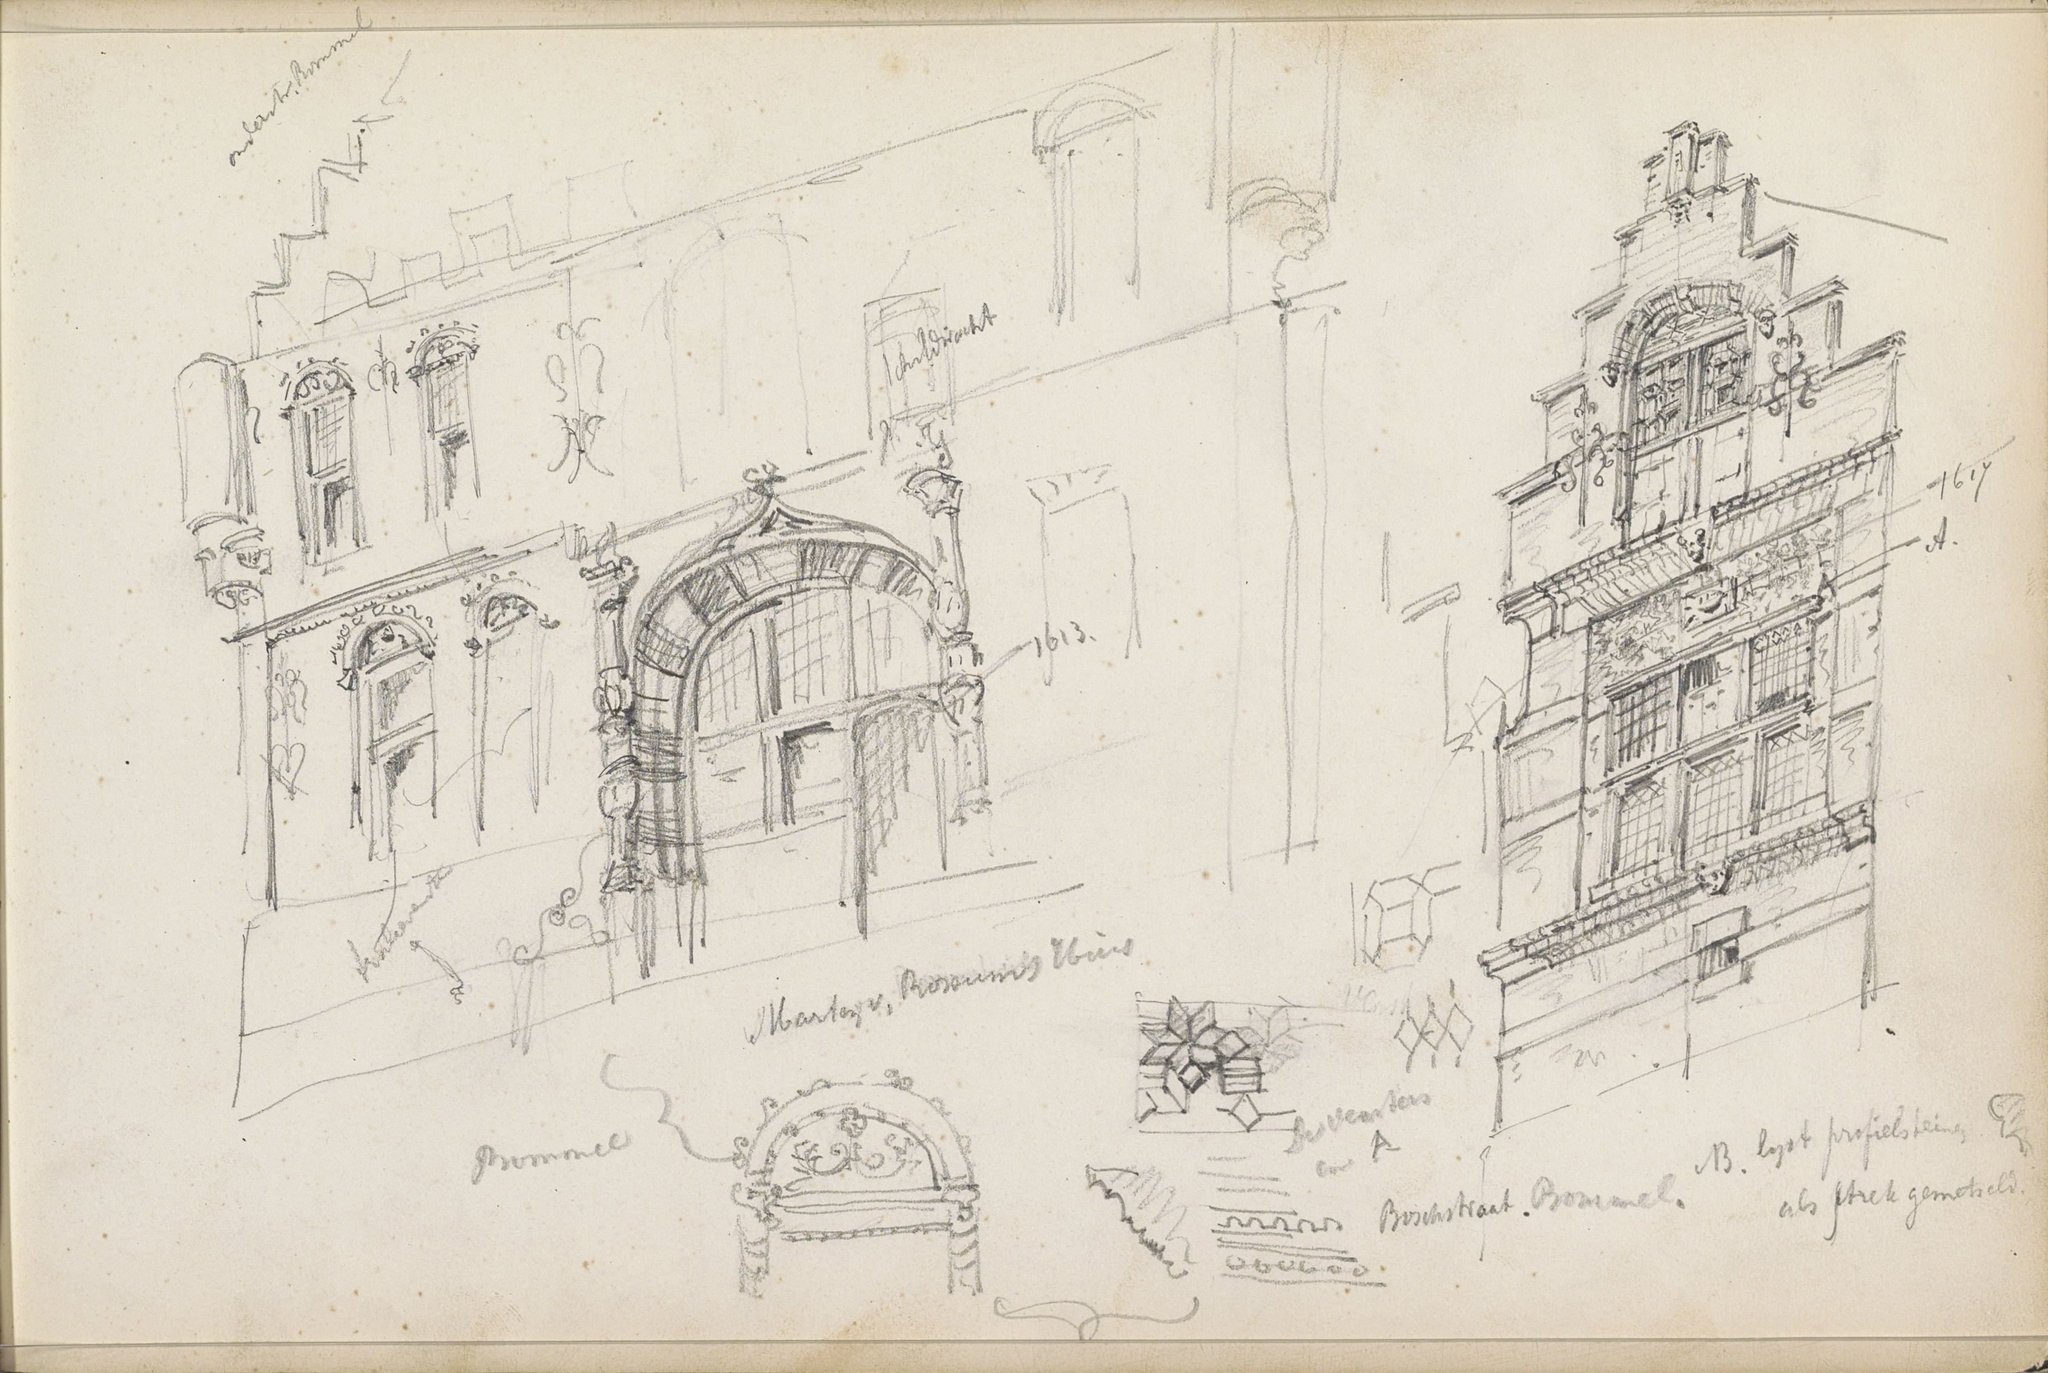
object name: sketchbook leaf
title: Maarten van Rossumhuis en gevel in de Boschstraat te Bommel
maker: isaac gosschalk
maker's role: draughtsman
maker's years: 1838-1907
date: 1862-1867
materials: paper, pencil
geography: bommel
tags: exterior ~ representation of a building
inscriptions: annotation: ‘[...]Bommel/ 1613/ Marten v. Rossums Huis/ Bommel/ 1617/ [...]/ Boschstraat Bommel/ vB lijst profielst[...]/ als [...] gemetseld’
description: Blad 45 recto uit een schetsboek met 58 bladen.